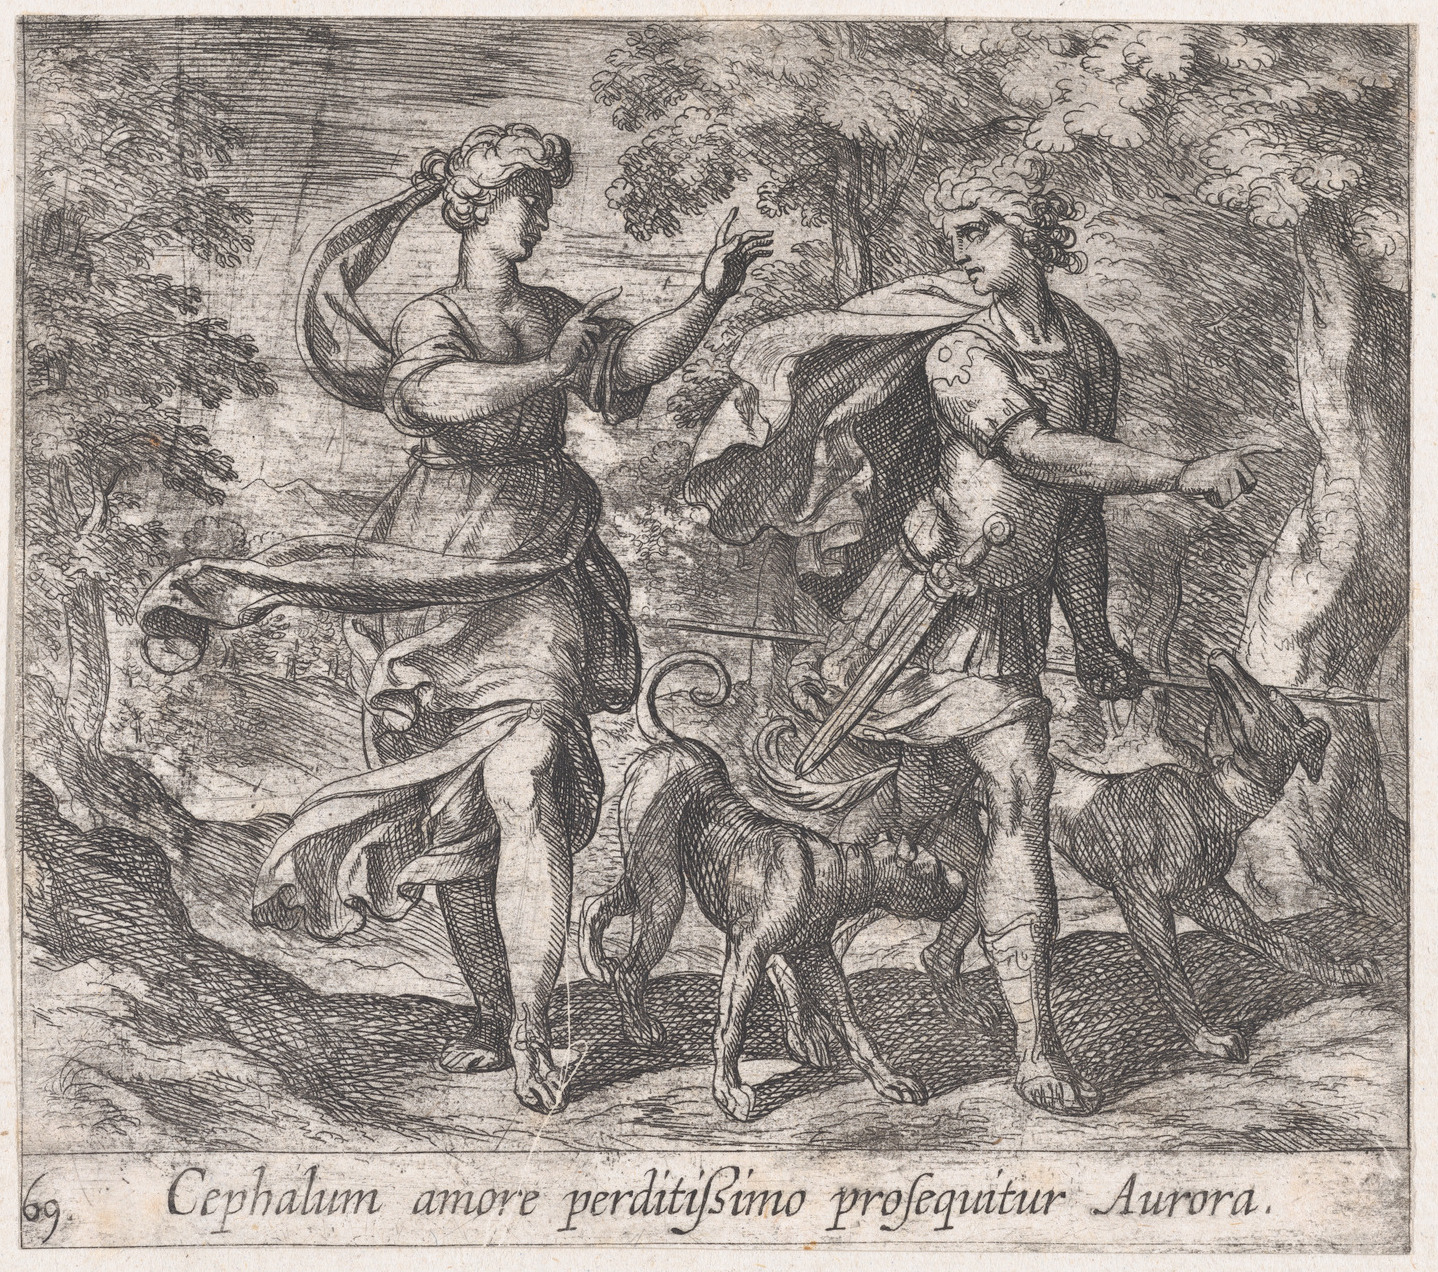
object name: print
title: Plate 69: Cephalus and Aurora (Cephalum amore perditißimo prosequitar Aurora), from Ovid's 'Metamorphoses'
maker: antonio tempesta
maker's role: artist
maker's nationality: italian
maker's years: 1555-1630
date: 1606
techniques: etching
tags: men,women,dogs